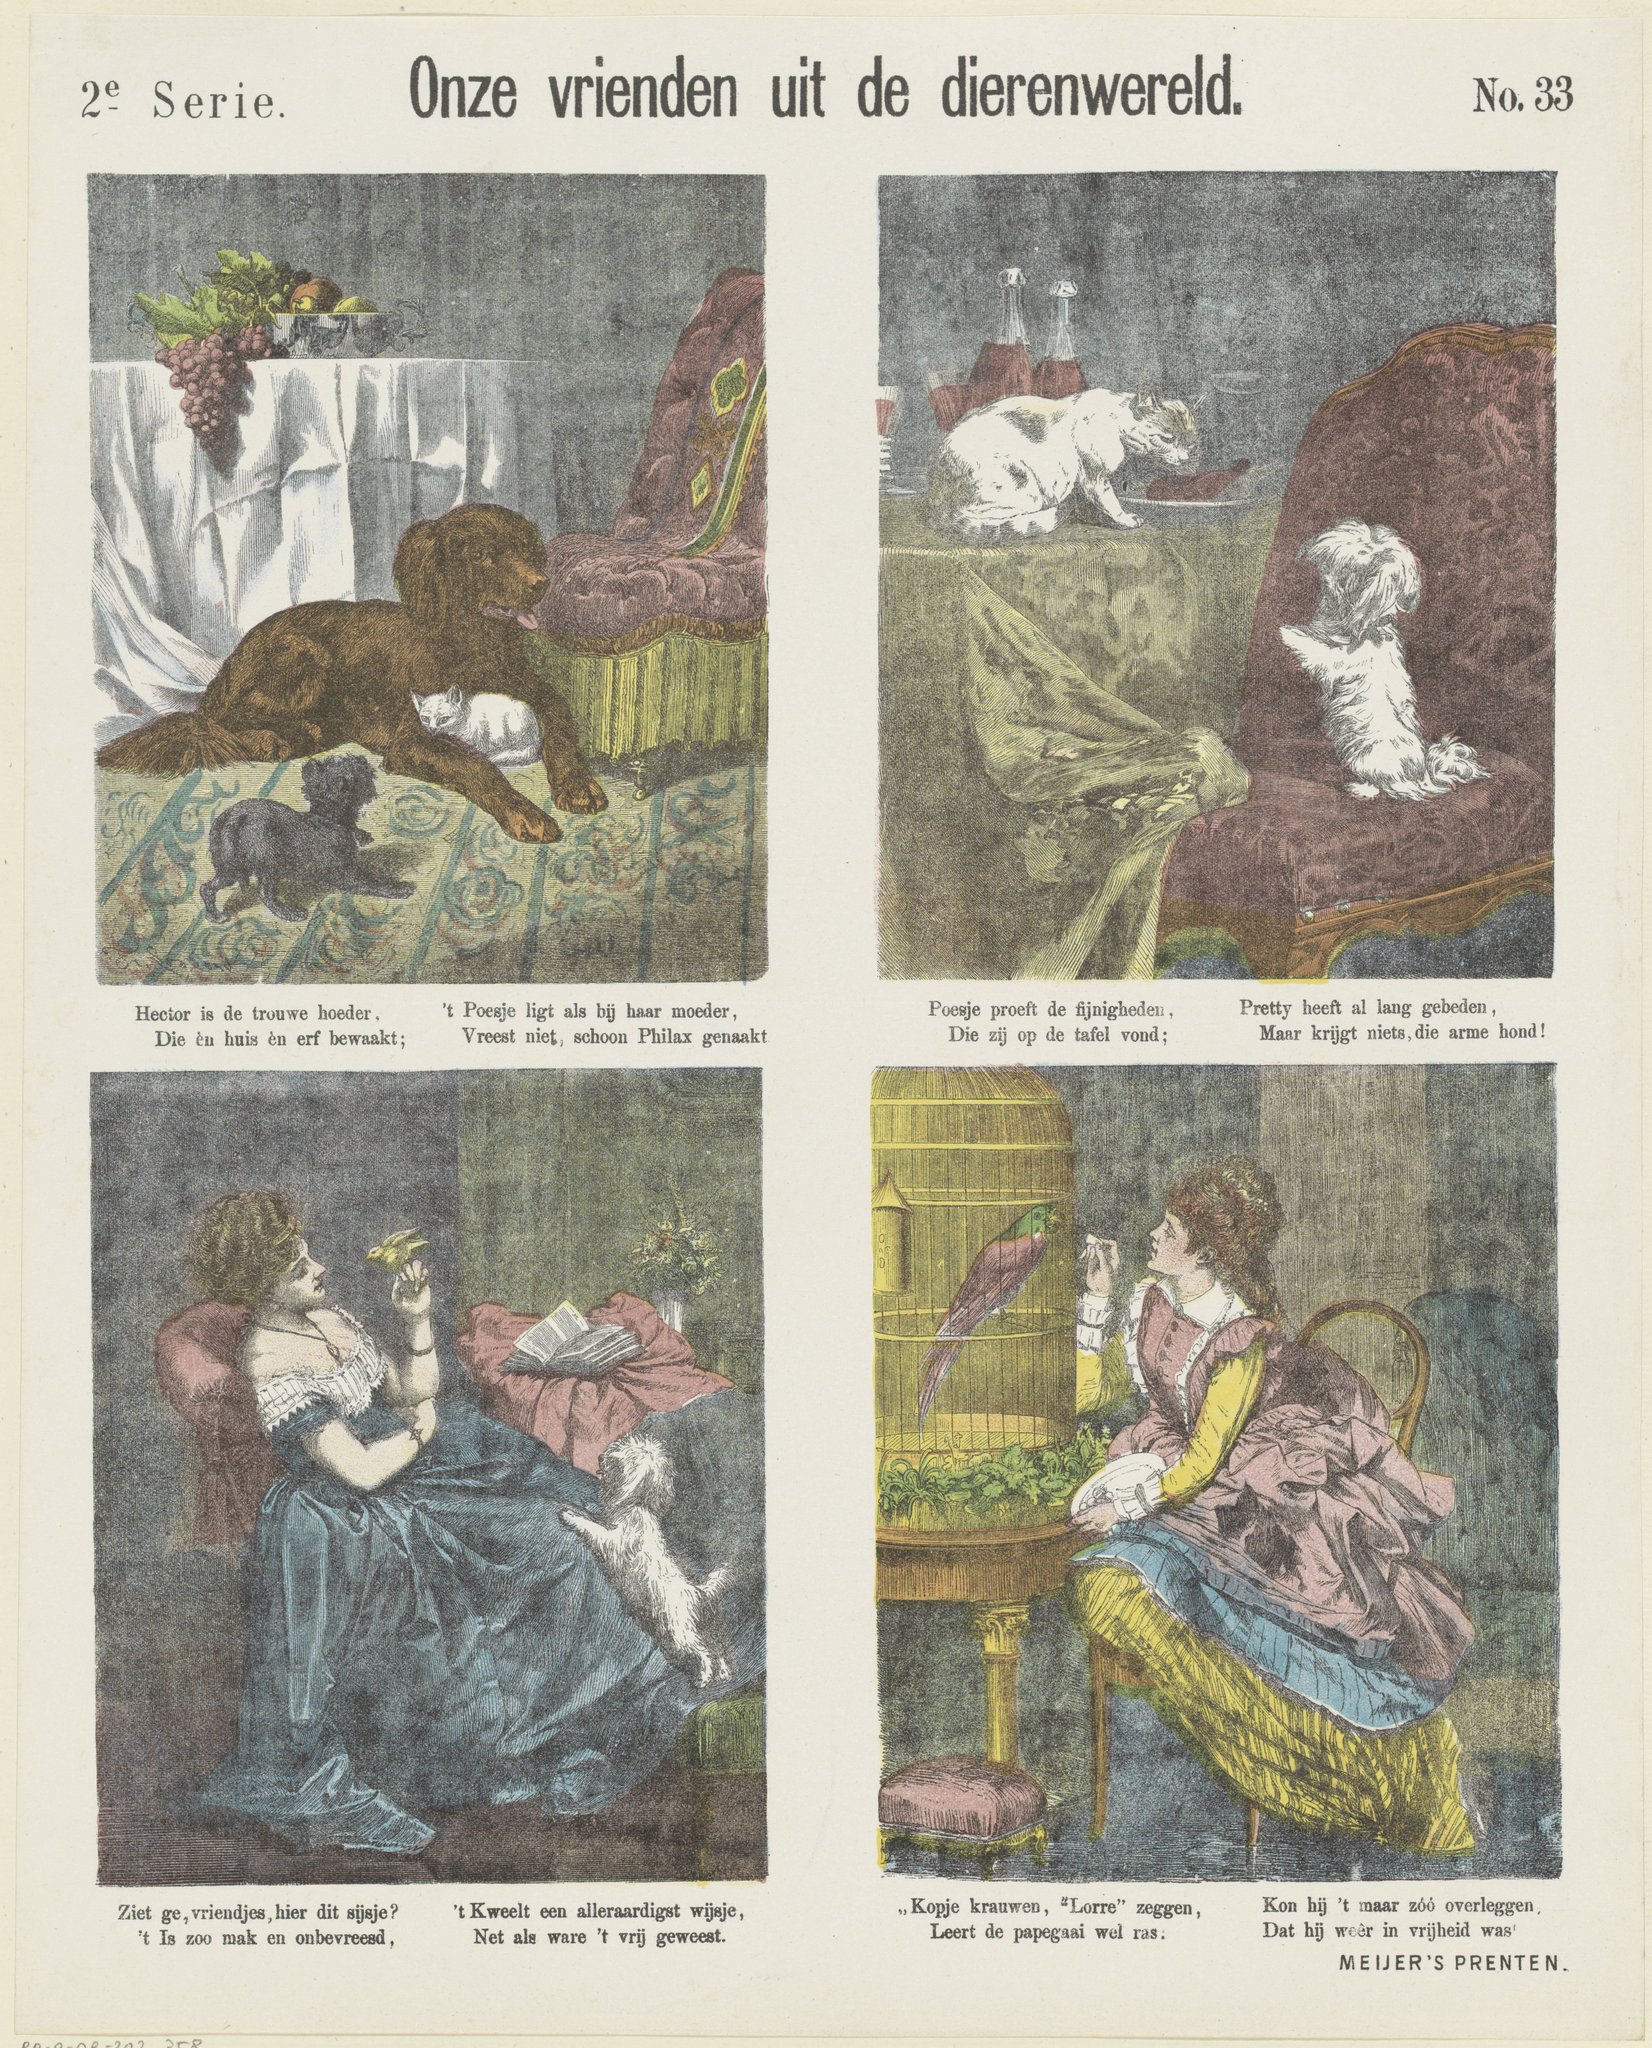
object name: popular print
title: Meijer's prenten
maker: Anonymous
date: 1874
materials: paper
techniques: lithograph, letterpress printing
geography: amsterdam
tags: cat, ornamental birds: parrot, friendship between man and animal; caressing, petting, dog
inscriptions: collector's mark: Lugt 2760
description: Blad met 4 voorstellingen van huisdieren, waaronder honden, een kat en een papegaai. Onder elke afbeelding een vierregelig vers in twee kolommen. Genummerd rechtsboven: No. 33.